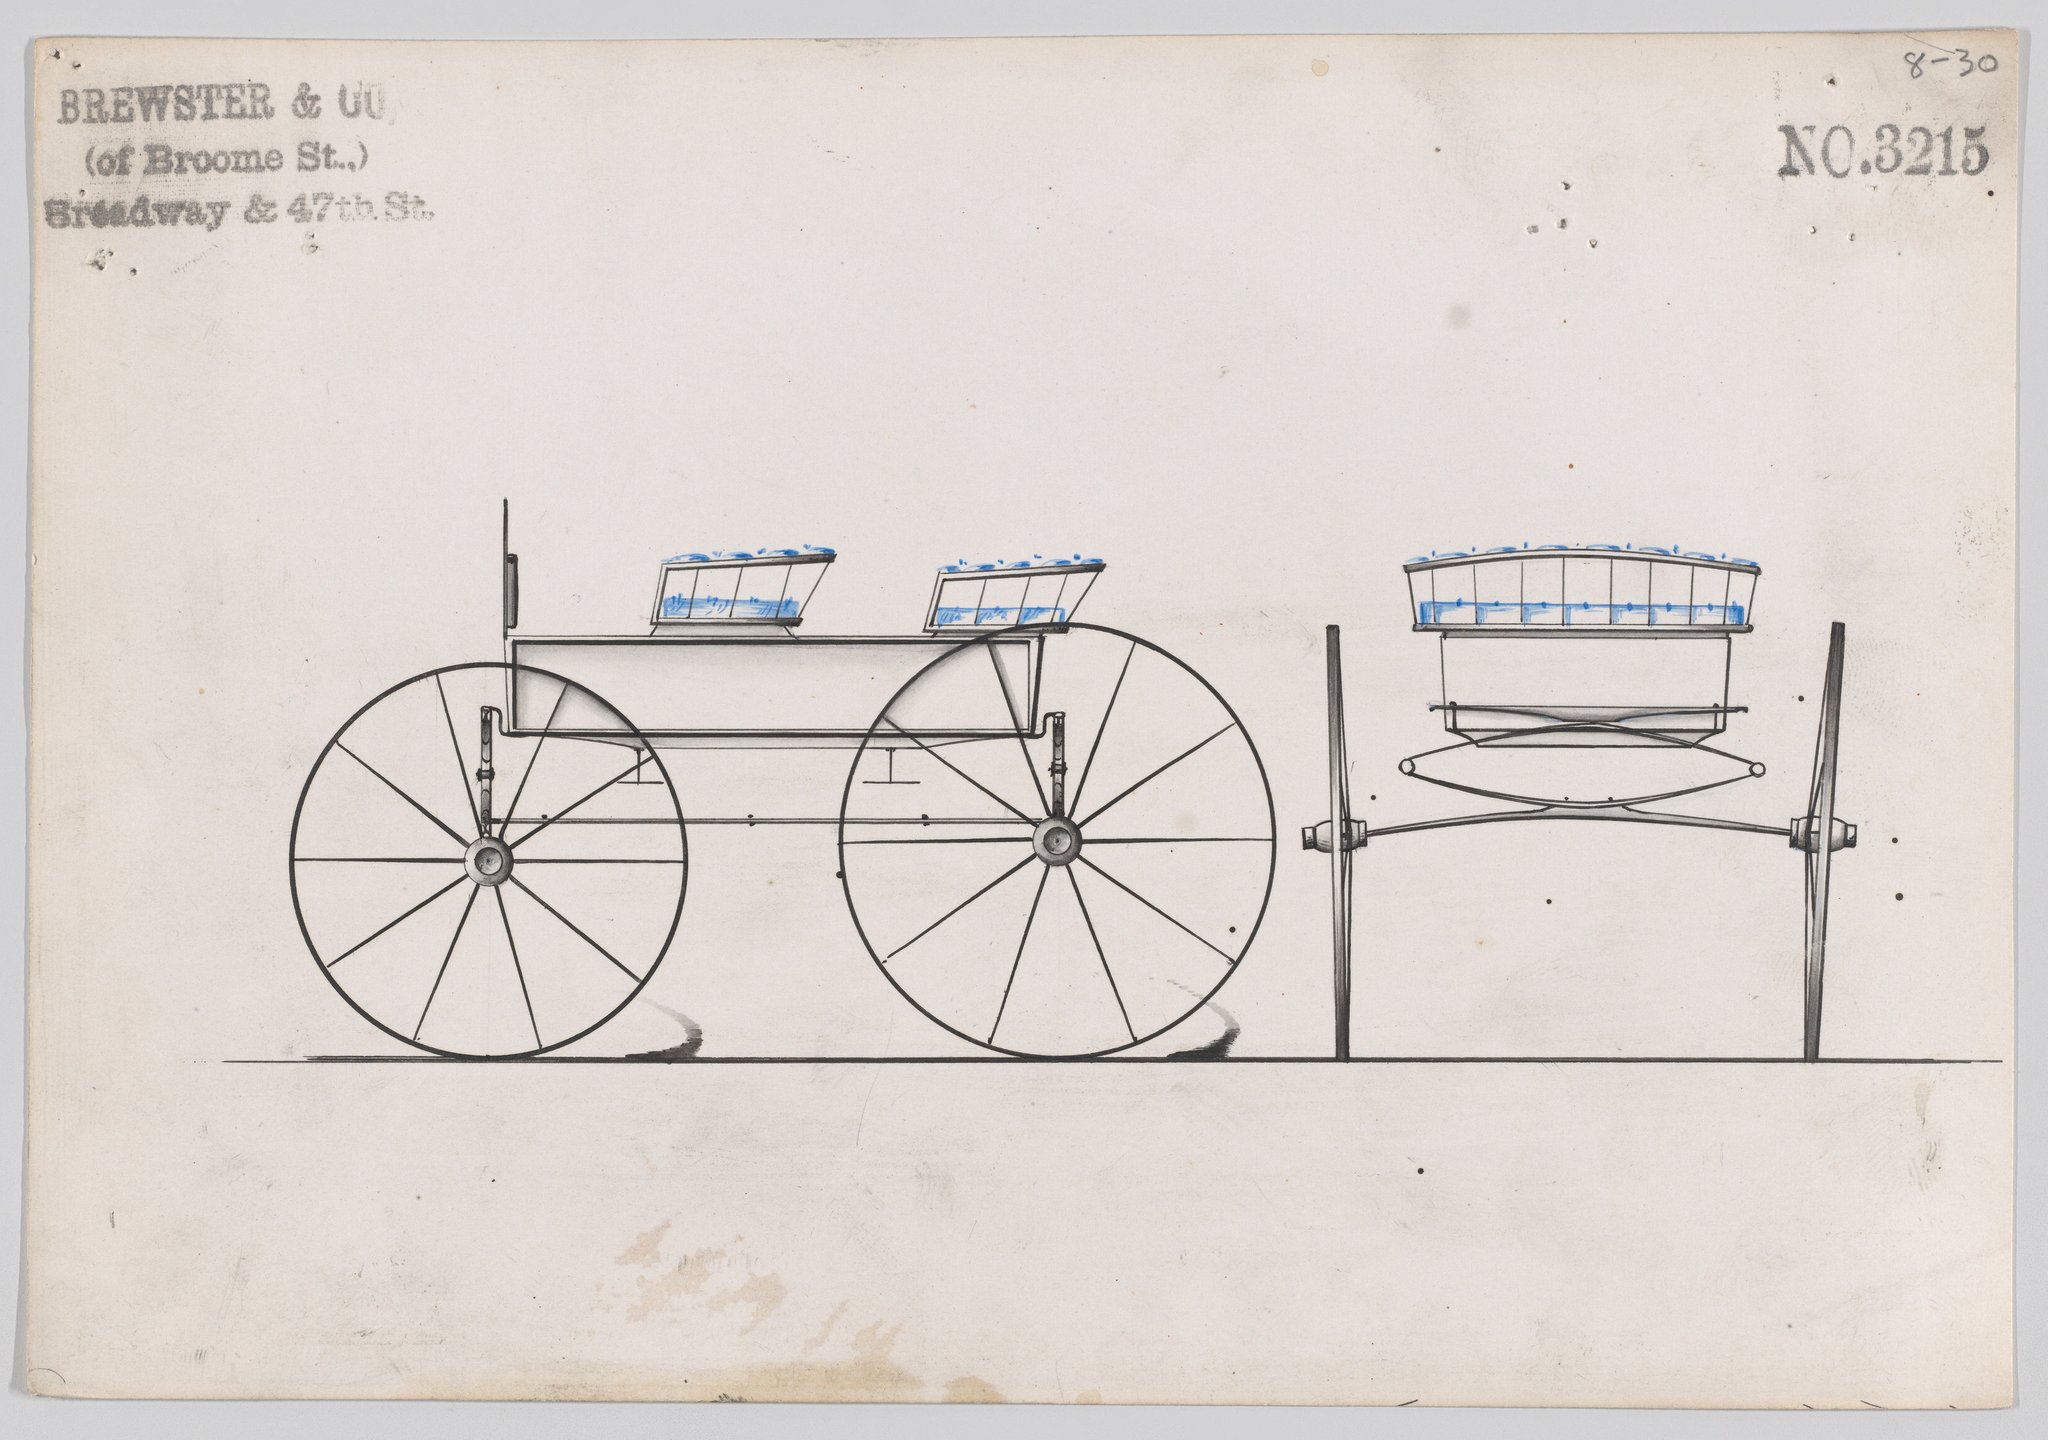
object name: drawing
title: Design for 4 seat Phaeton, no top, no. 3215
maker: brewster & co.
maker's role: manufacturer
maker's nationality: american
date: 1876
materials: gouache, ink, watercolor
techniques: pen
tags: carriages